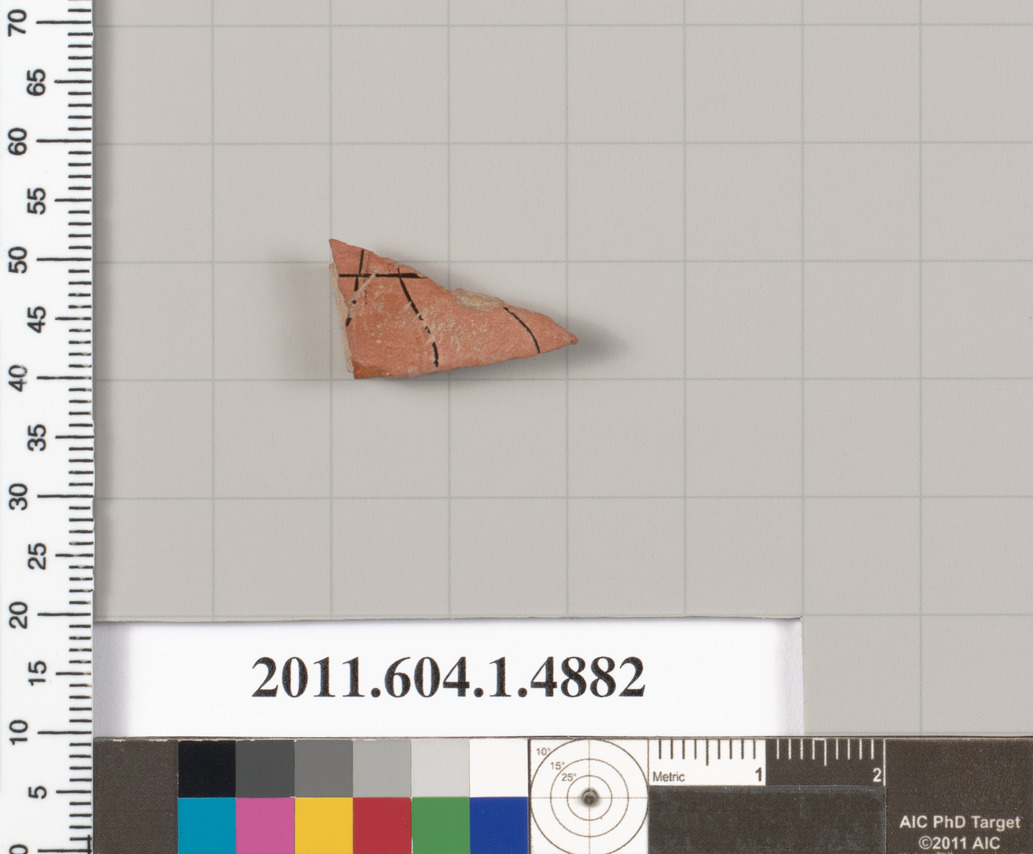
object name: kylix fragment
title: Terracotta fragment of a kylix (drinking cup)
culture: greek, attic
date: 475-451 BCE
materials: terracotta